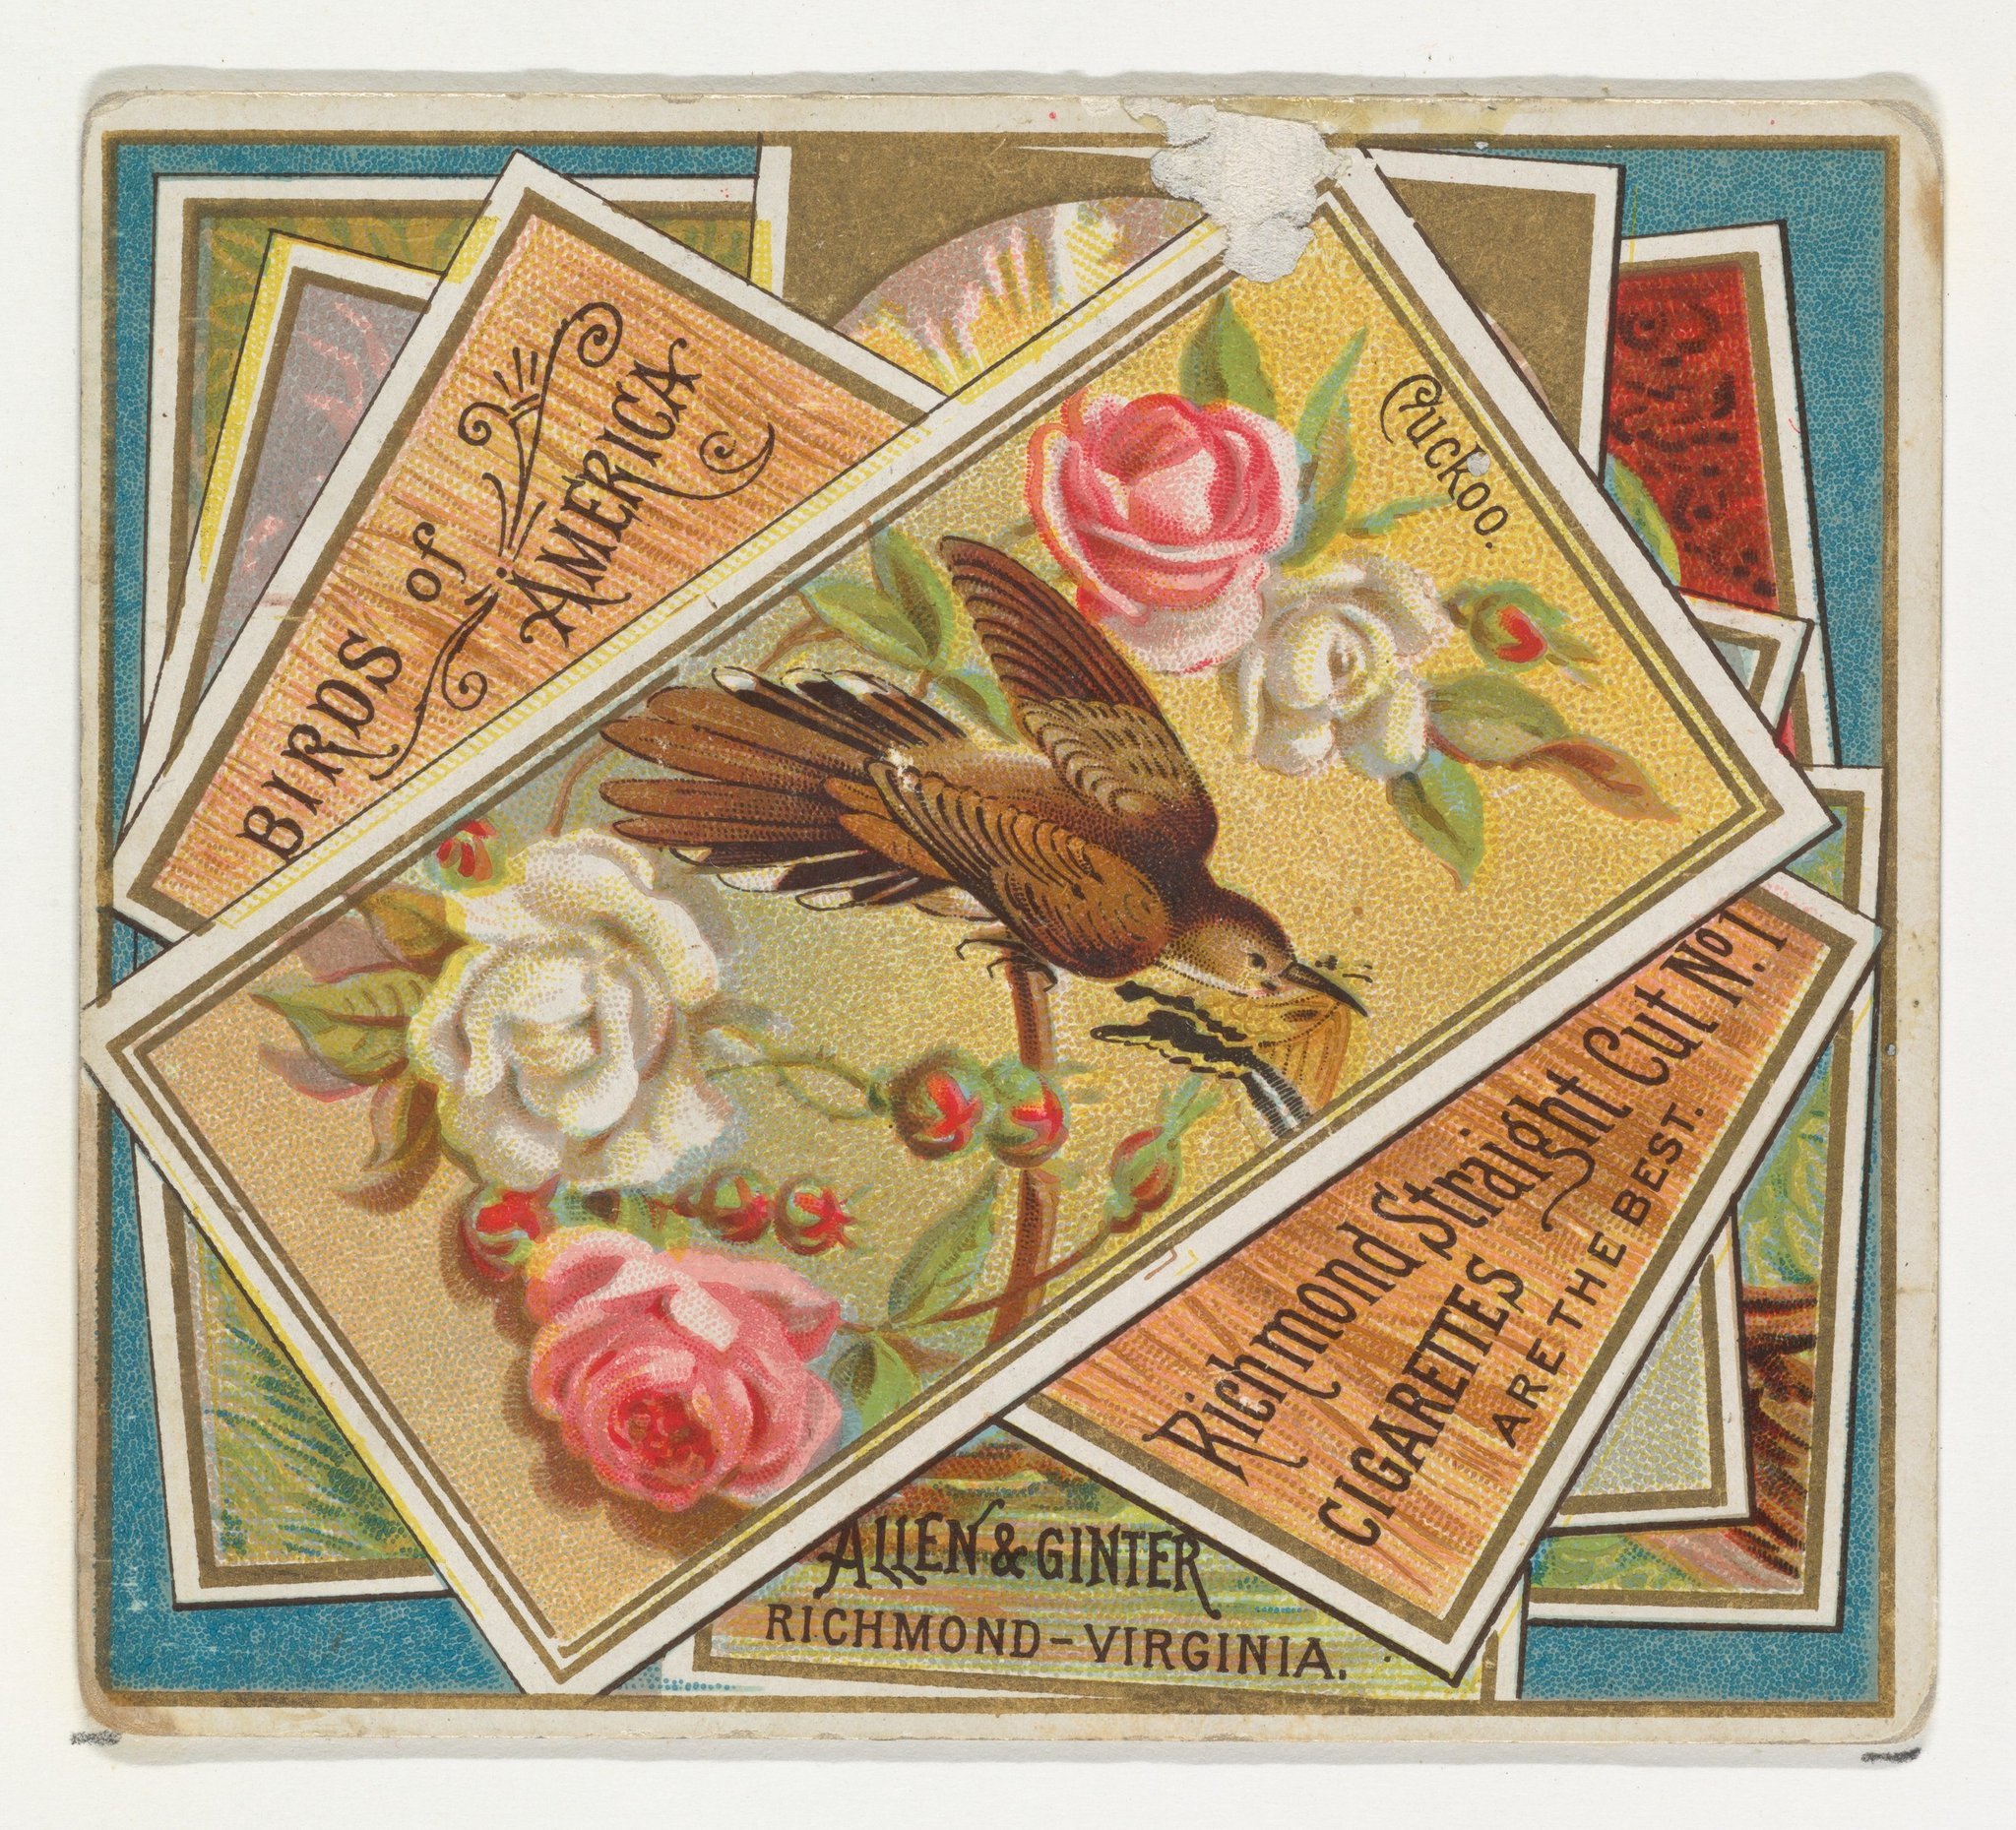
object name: print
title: Cuckoo, from the Birds of America series (N37) for Allen & Ginter Cigarettes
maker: allen & ginter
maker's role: publisher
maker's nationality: american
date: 1888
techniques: color lithograph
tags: birds